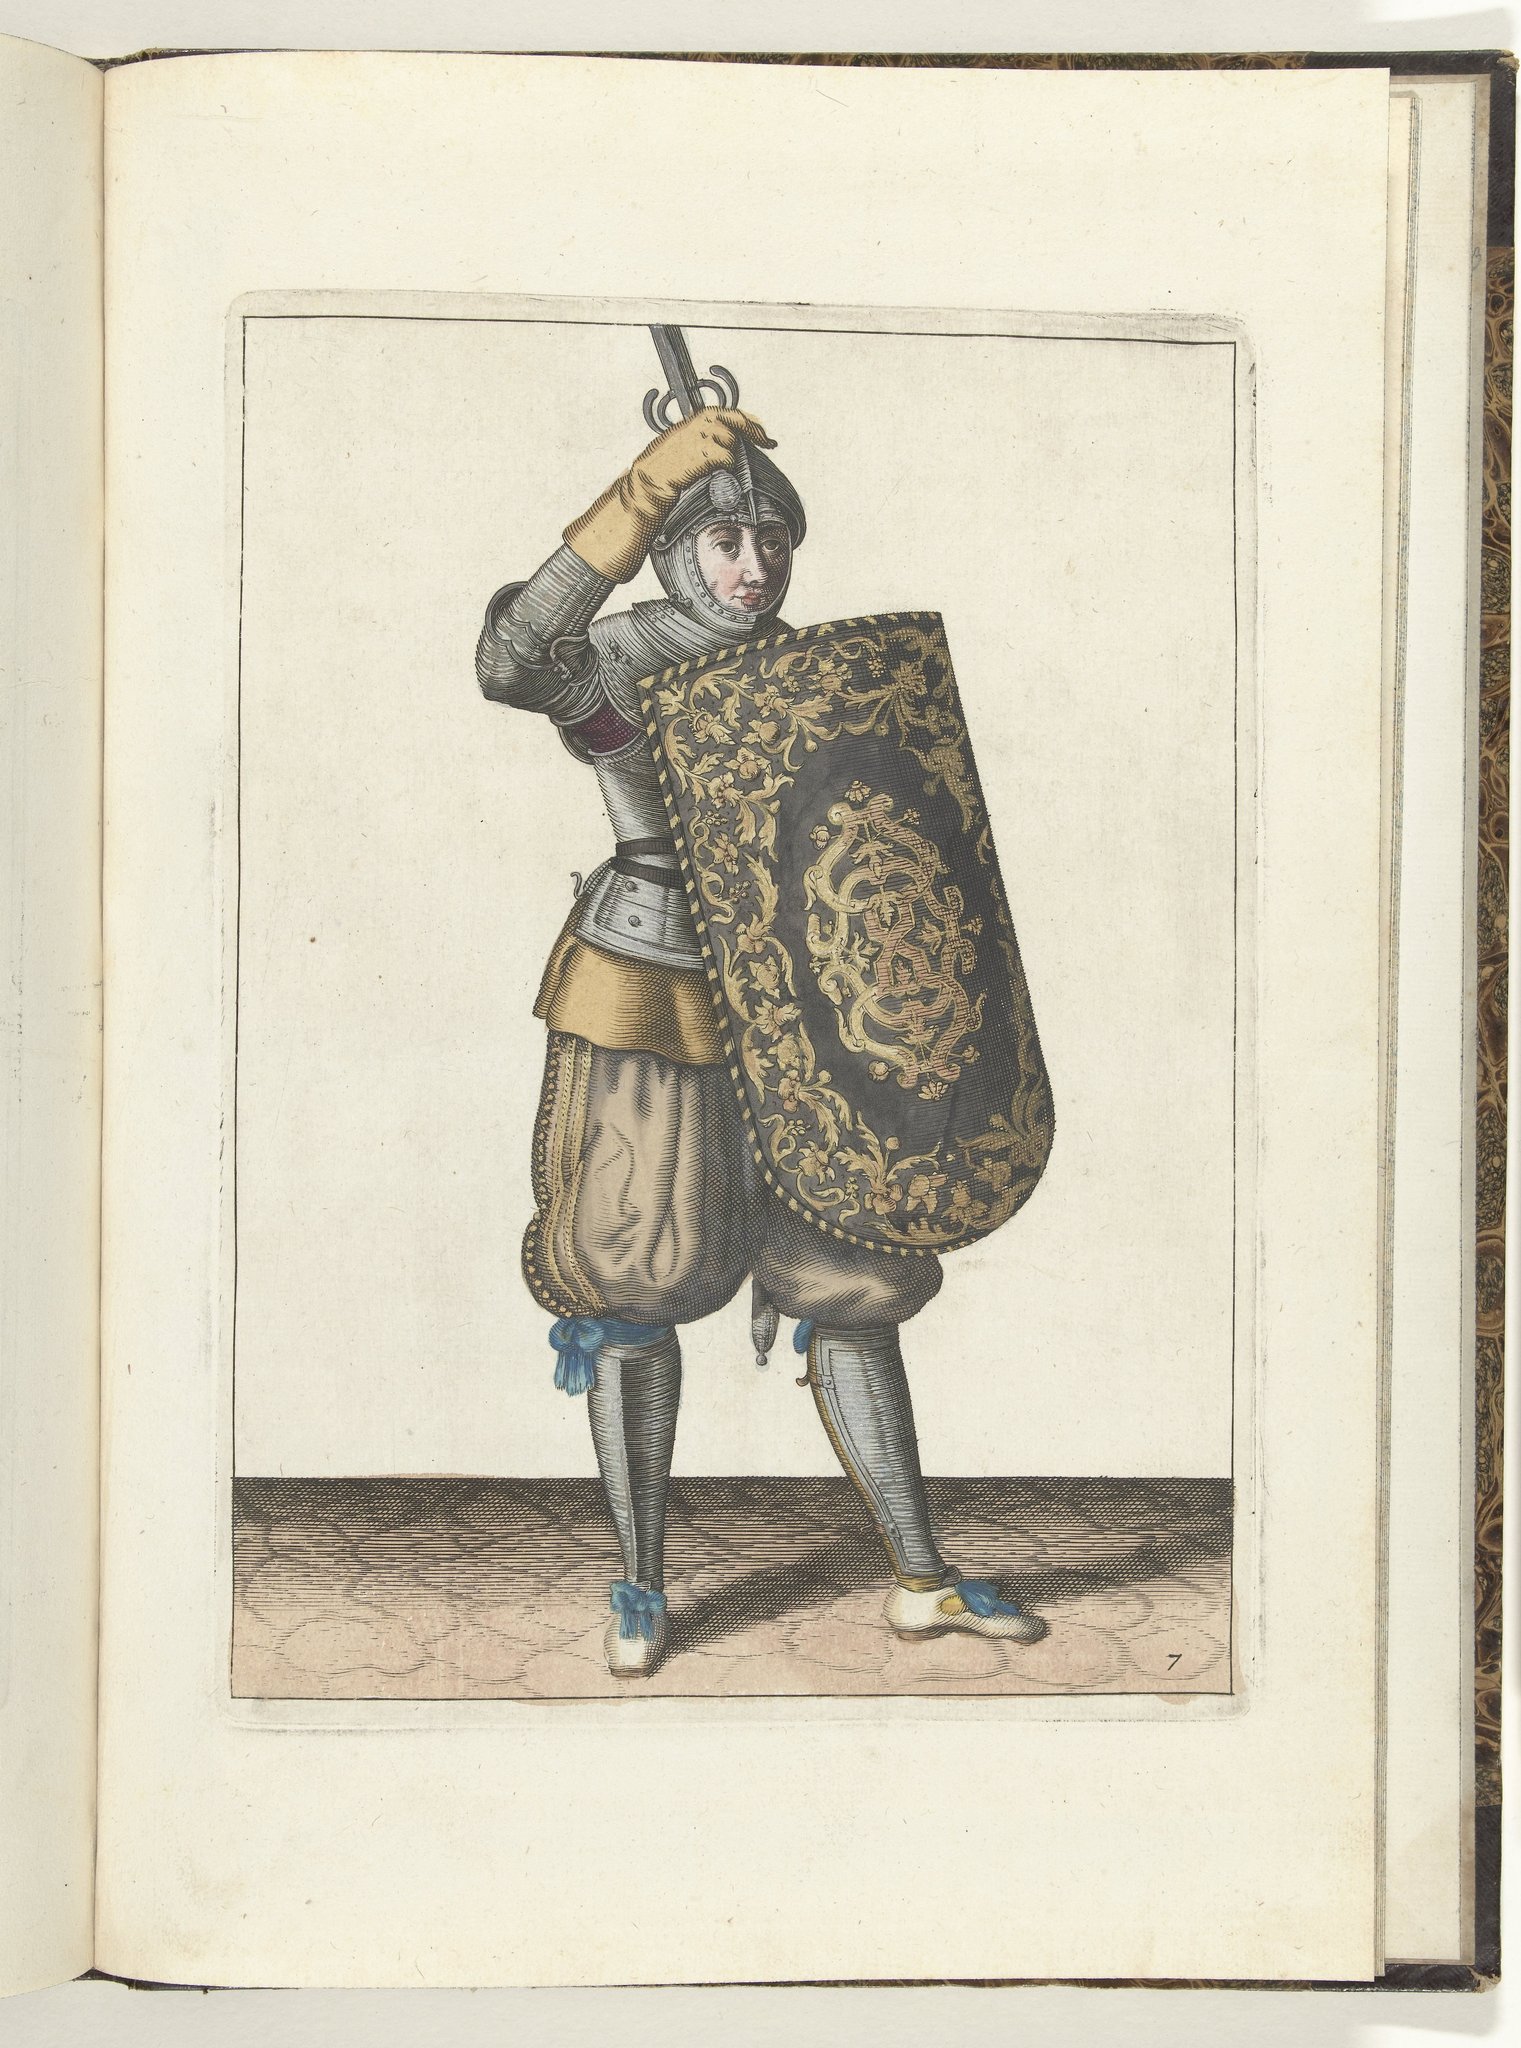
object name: print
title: De exercitie met de targe en rapier: hoe de soldaat het vizier van zijn helm moet sluiten met de targe en de getrokken rapier in de hand (nr. 7), 1618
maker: Anonymous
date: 1616-1618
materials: paper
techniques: engraving, hand coloring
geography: northern netherlands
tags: maurice (prince of orange), handling of weapons ~ military training, weapons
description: Illustratie in: Adam van Breen, Nassauische Waffenhandelung / Kurtzer Bericht unnd Ahnzeigungh auff die Ab-bildungh der Figuren / den rechten brauch alles des jenigen betreffend / so einem Soldaten von nöten / in der handlung der Targa, met dem Degen [incompleet exemplaar], 1618?, plaat 7. Dit is een Duitse editie van Adam van Breens De Nassausche Wapen-Handelinge, van Schilt, Spies, Rappier ende Targe : beyde figuerlick afgebeelt, ende gestelt na de nieu ordening [van] ... Maurits van Nassau, 's-Gravenhage, [Aert Meuris] 1618. In het exemplaar in de collectie van de Rijksmuseum Research Library (326 F 23).